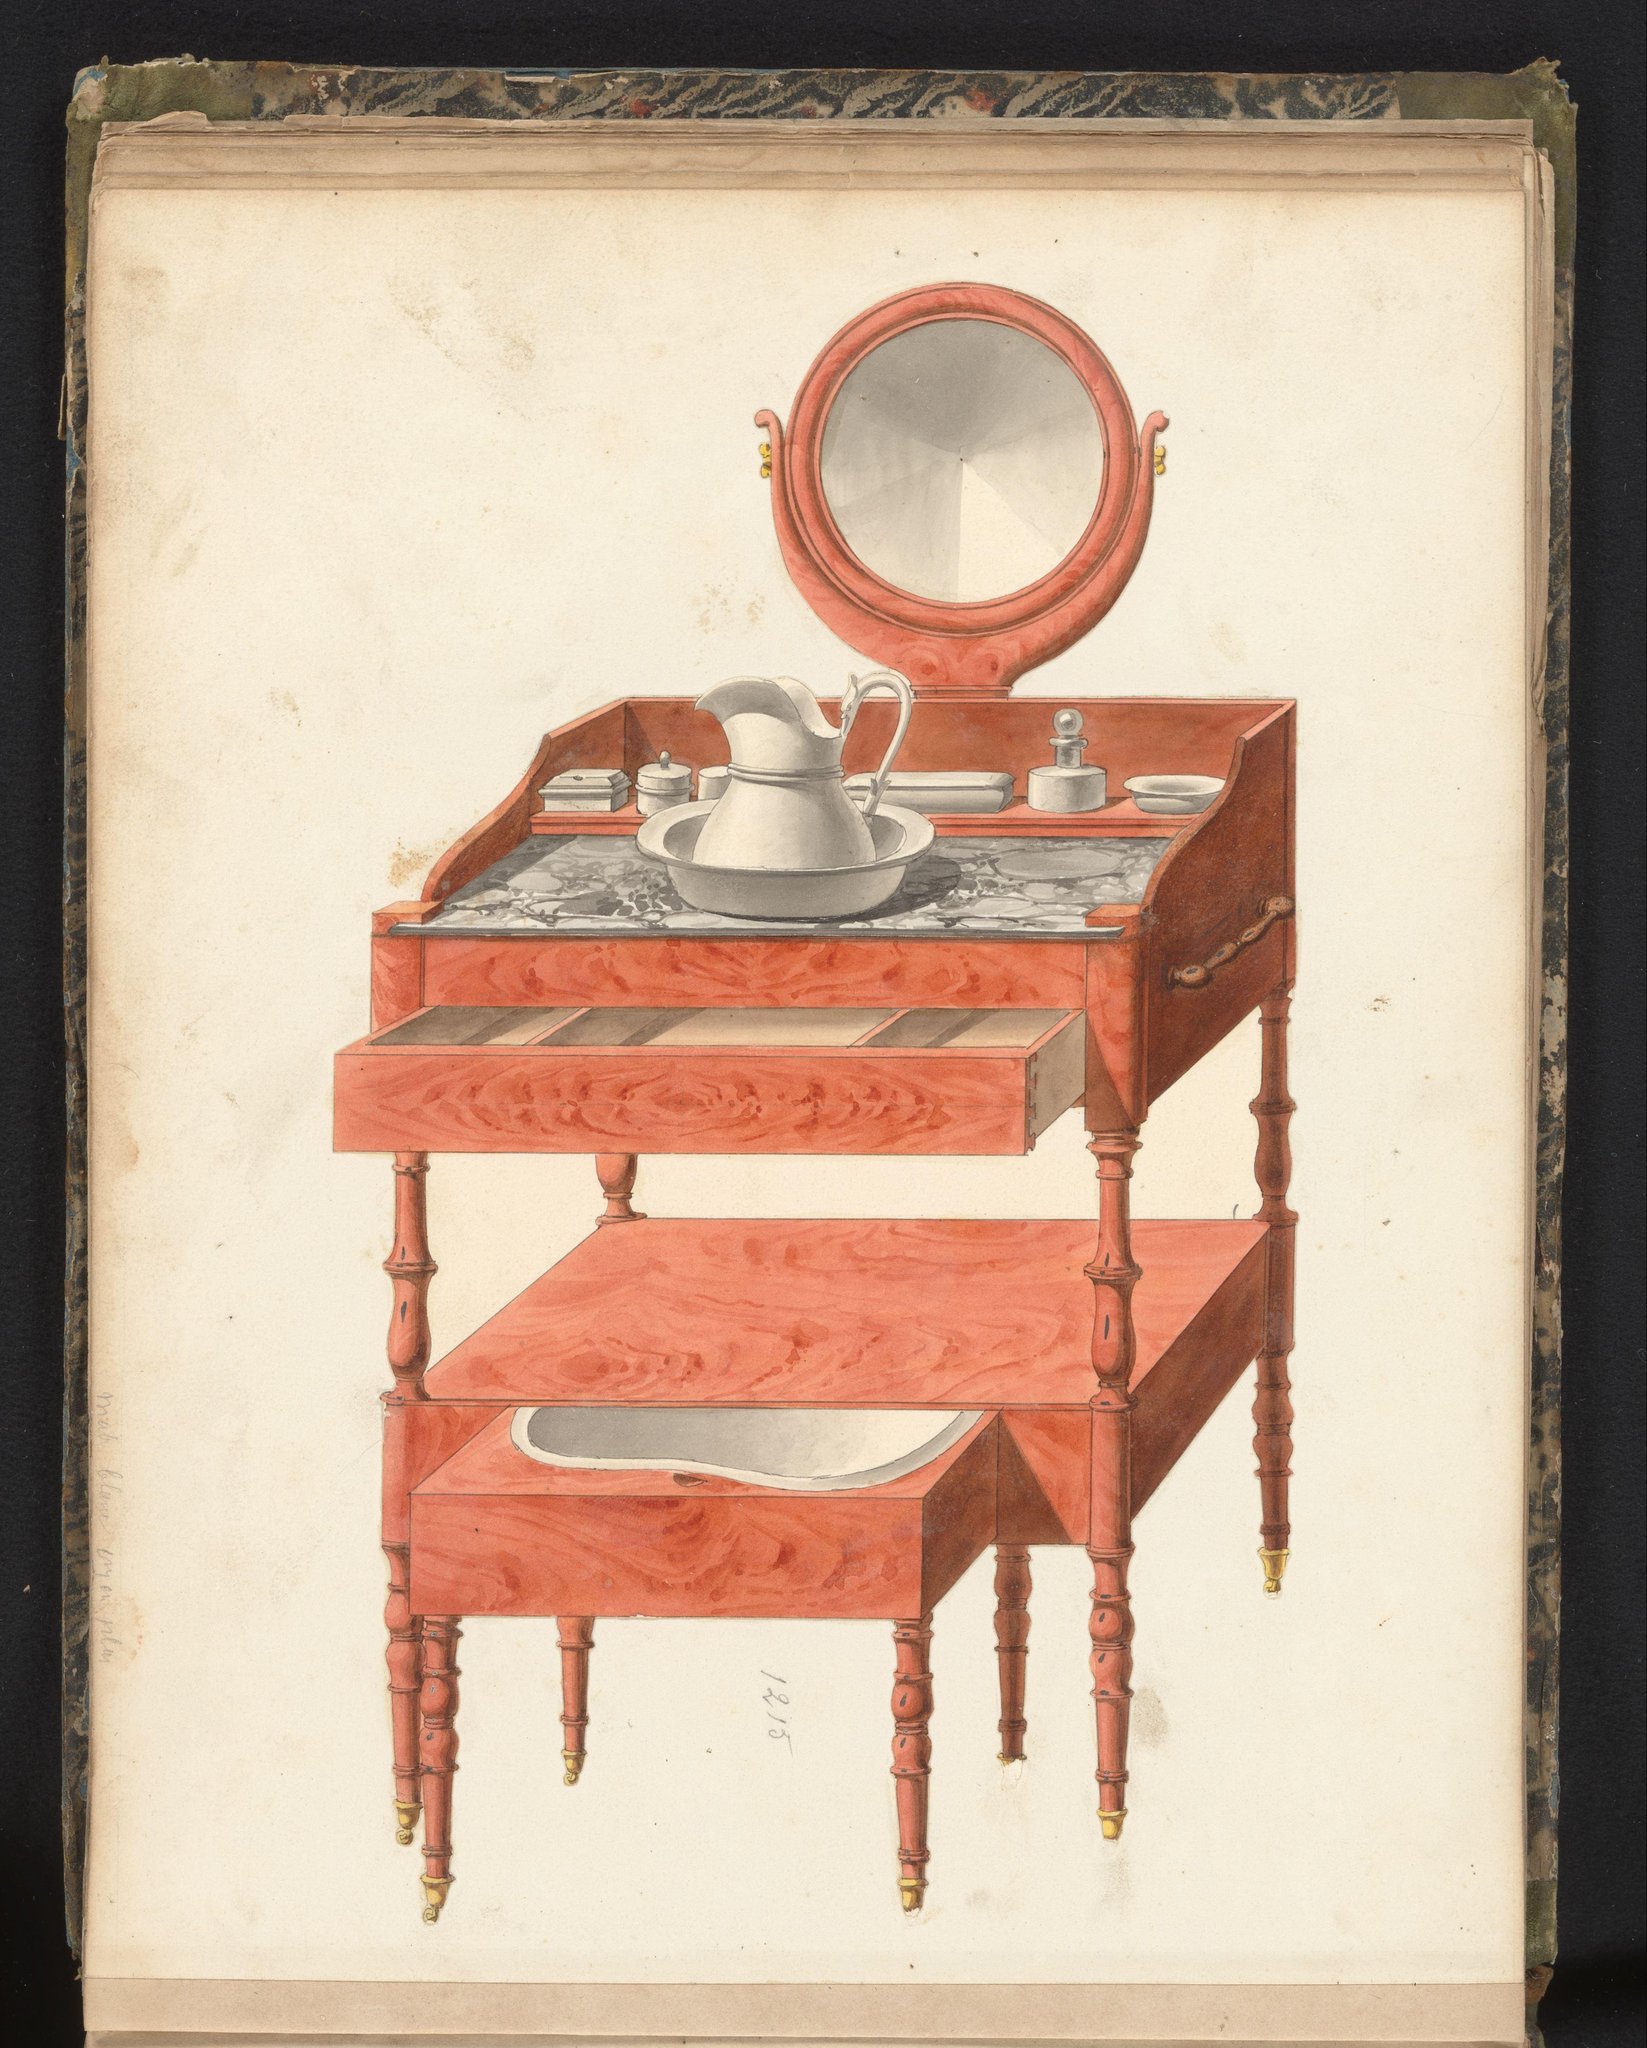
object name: album leaf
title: Ontwerp voor een toilettafel met ingebouwde bidet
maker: Anonymous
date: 1825-1839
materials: ink, paper, pencil, watercolor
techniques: brush, pen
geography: paris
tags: mirror, jug and basin; wash-basin, bidet, furniture for special use (+ wood and other phytogenic material), table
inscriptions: inscription: ‘1215 Toilette Anglaise à bidet 4 pies tournée 28po gre (gu?) porcelaine & cristeaux la même en noyer’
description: Toilettafel met marmeren blad en spiegel en ingebouwde bidet op rollers. Het blad op de achterzijde genummerd: 8, het tegenoverliggende blad met informatie over de afgebeelde meubelen genummerd: 8 bis. Onderdeel van een album met 80 bladen met tekeningen en een prent van gefineerde en gelakte meubelen, alsmede zitmeubelen.